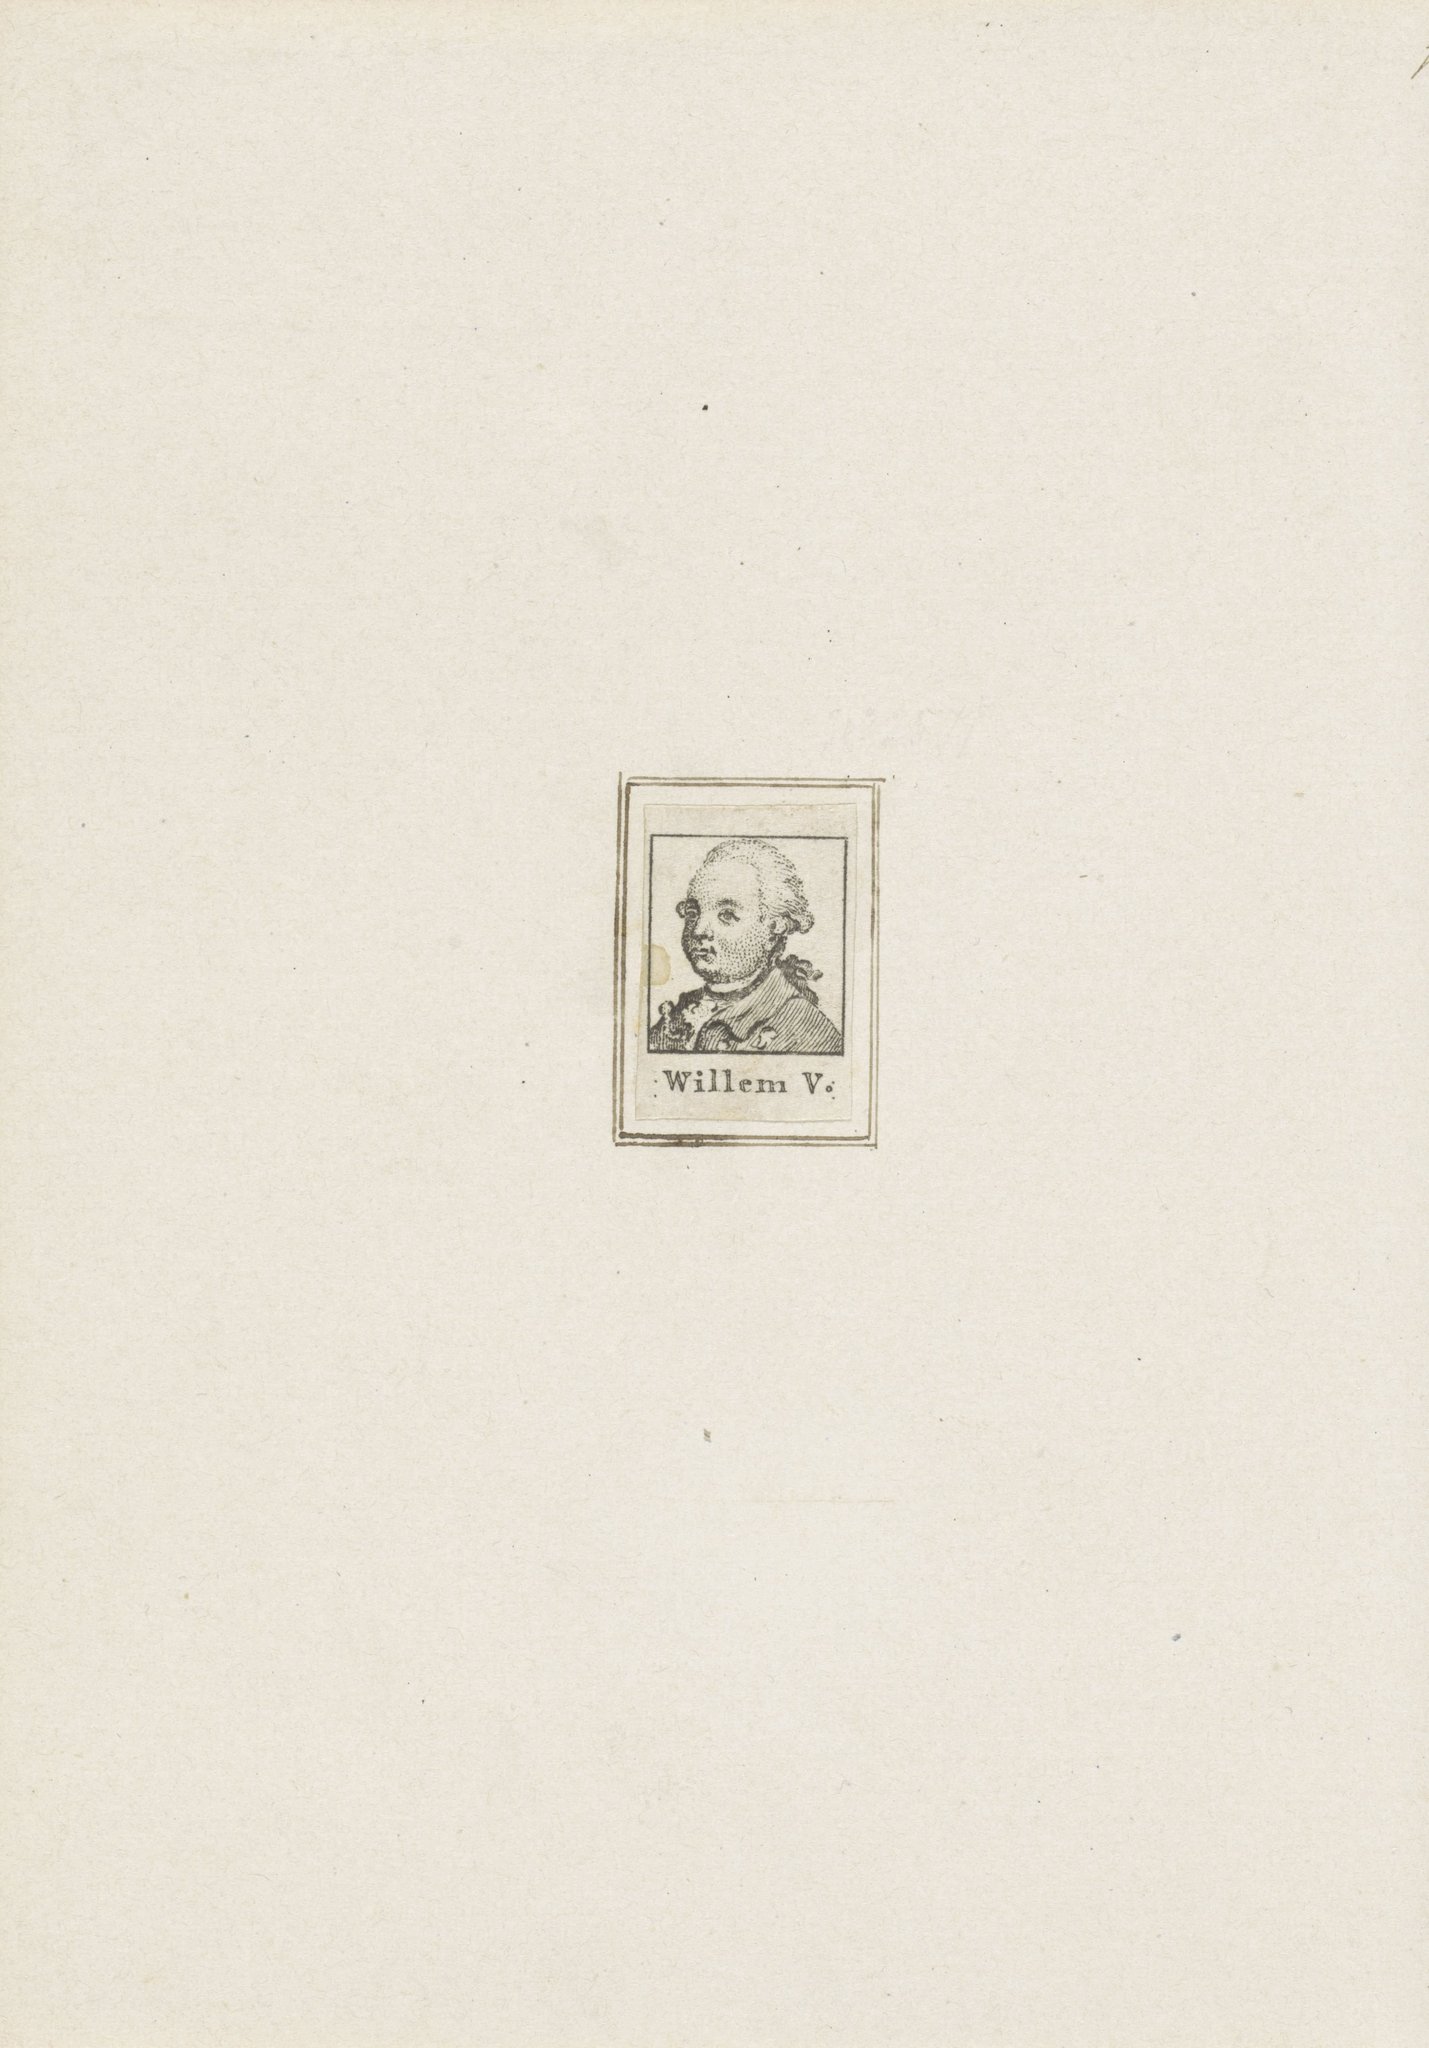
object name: print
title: Portret van Willem V, prins van Oranje-Nassau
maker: Anonymous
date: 1775-1849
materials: paper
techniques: engraving, etching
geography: low countries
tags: the hague, william v (prince of orange)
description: De hier vermelde titel verwijst naar de hoogst verkregen titel van de geportretteerde, niet per se naar de titel die de geportretteerde op deze voorstelling draagt.